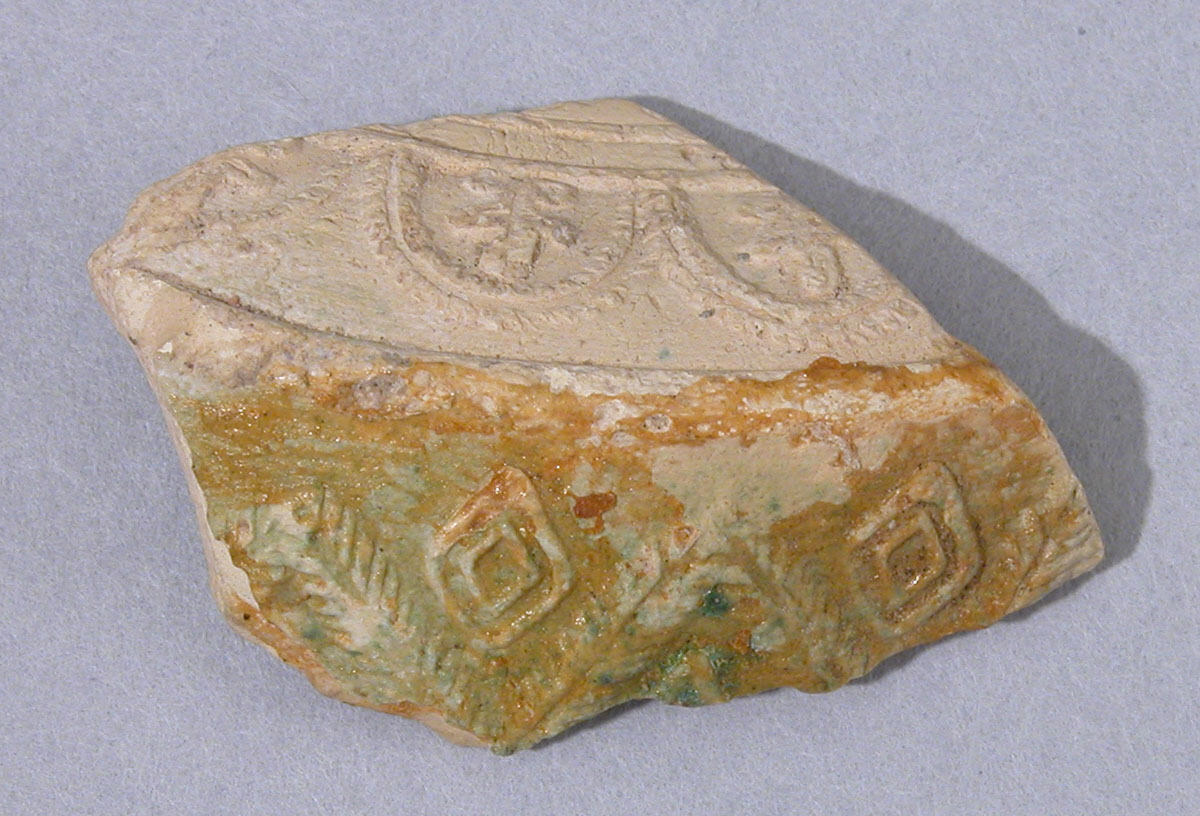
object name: fragment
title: Ceramic Fragment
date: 801-900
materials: earthenware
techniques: glazing, molding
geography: saudi arabia